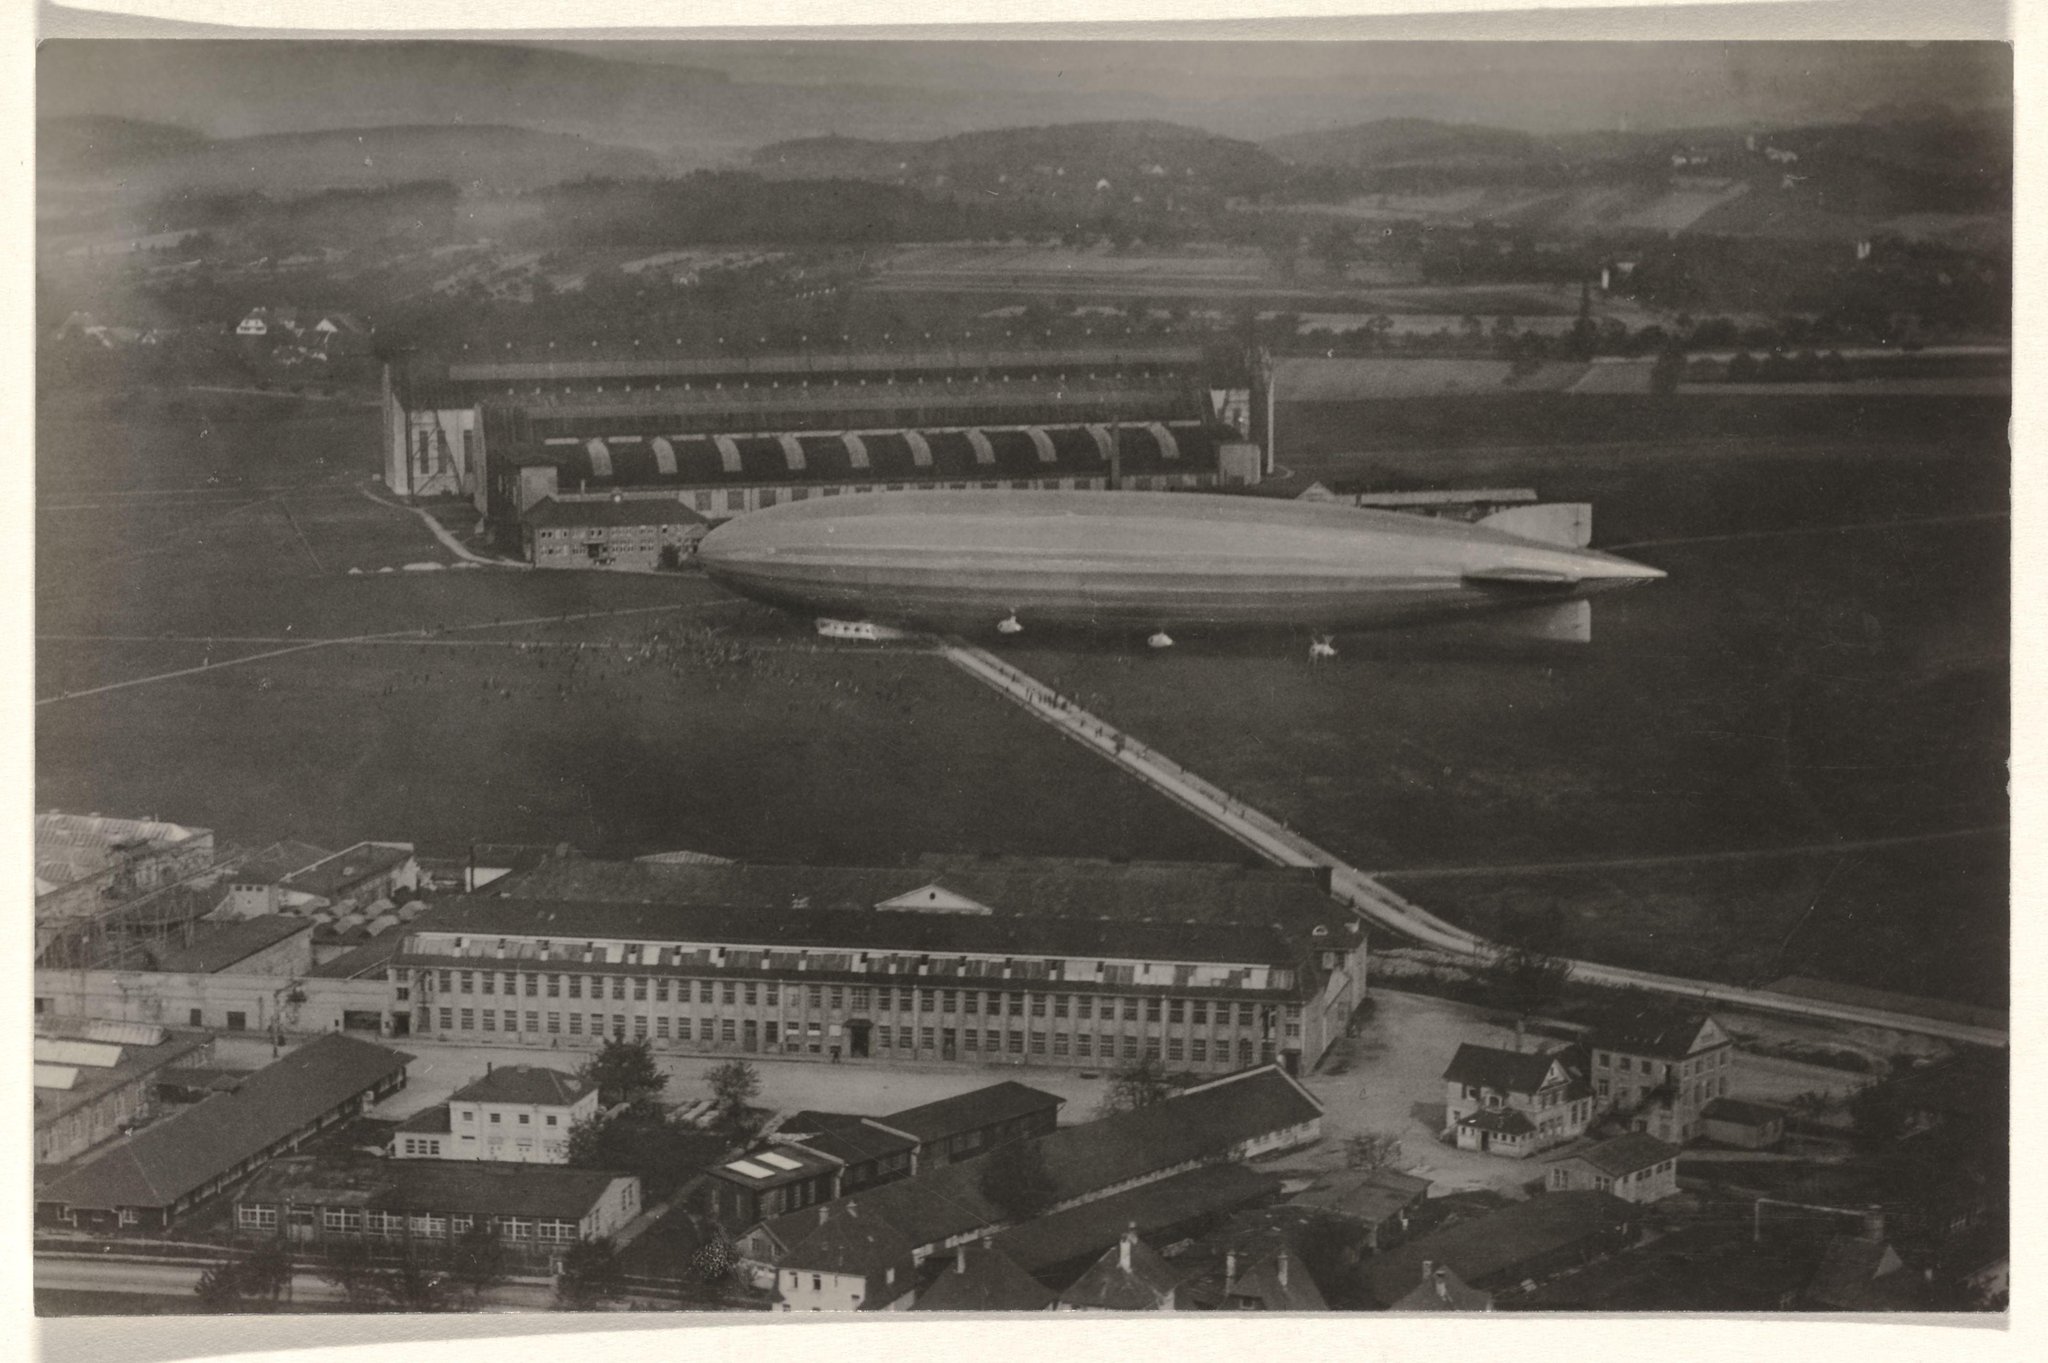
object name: photograph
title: De Amerika-zeppelin ZR 3 bij de landing voor een hangar in Friedrichshafen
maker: Anonymous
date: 1924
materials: photographic support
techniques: gelatin silver print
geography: friedrichshafen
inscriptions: inscription: ‘AMERIKA-ZEPPELIN Z R III nach der Landung vor seiner Halle (Aufgenommen von Prof. Maerker aus dem Dornier Flugboot von Ing. Trückenbrodt, Konstanz)’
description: Een zeppelin in de lucht met een hangar op de grond en gebouwen op de voorgrond.